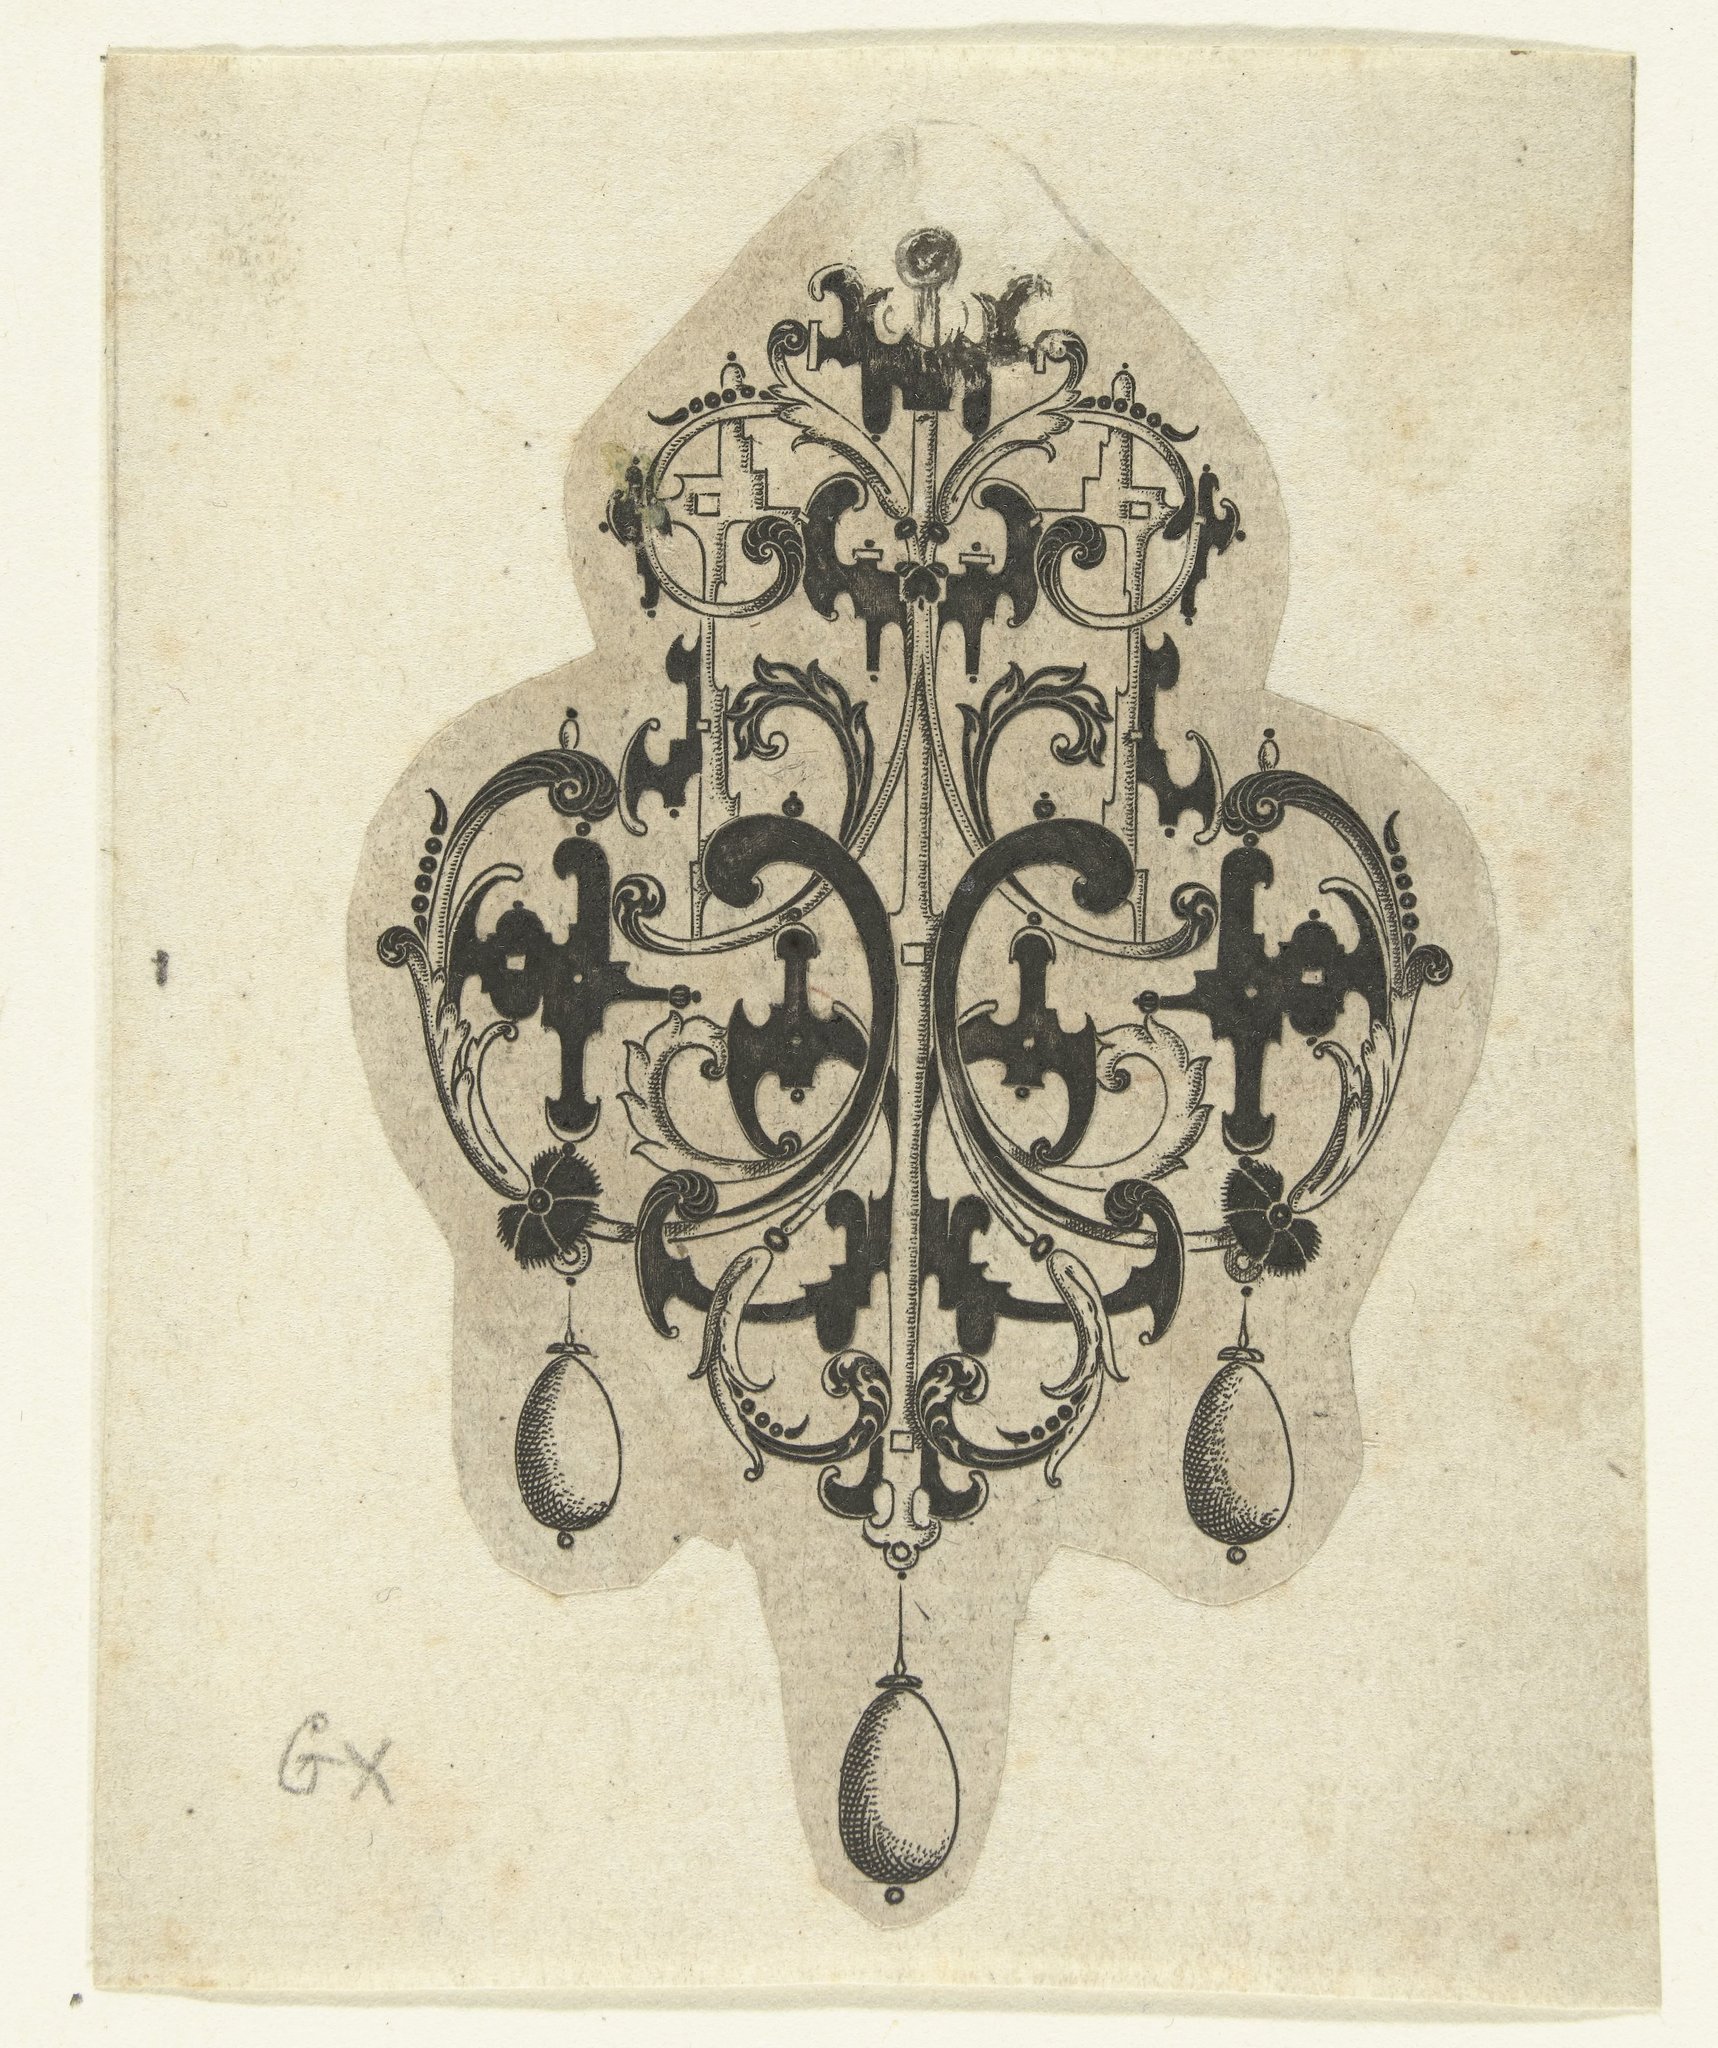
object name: ornament print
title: In timore de (...)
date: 1596-1616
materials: paper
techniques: engraving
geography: germany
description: Onderaan hangen drie parels. Blad afkomstig uit een serie, bestaande uit een titelblad en 7 bladen met hangers.